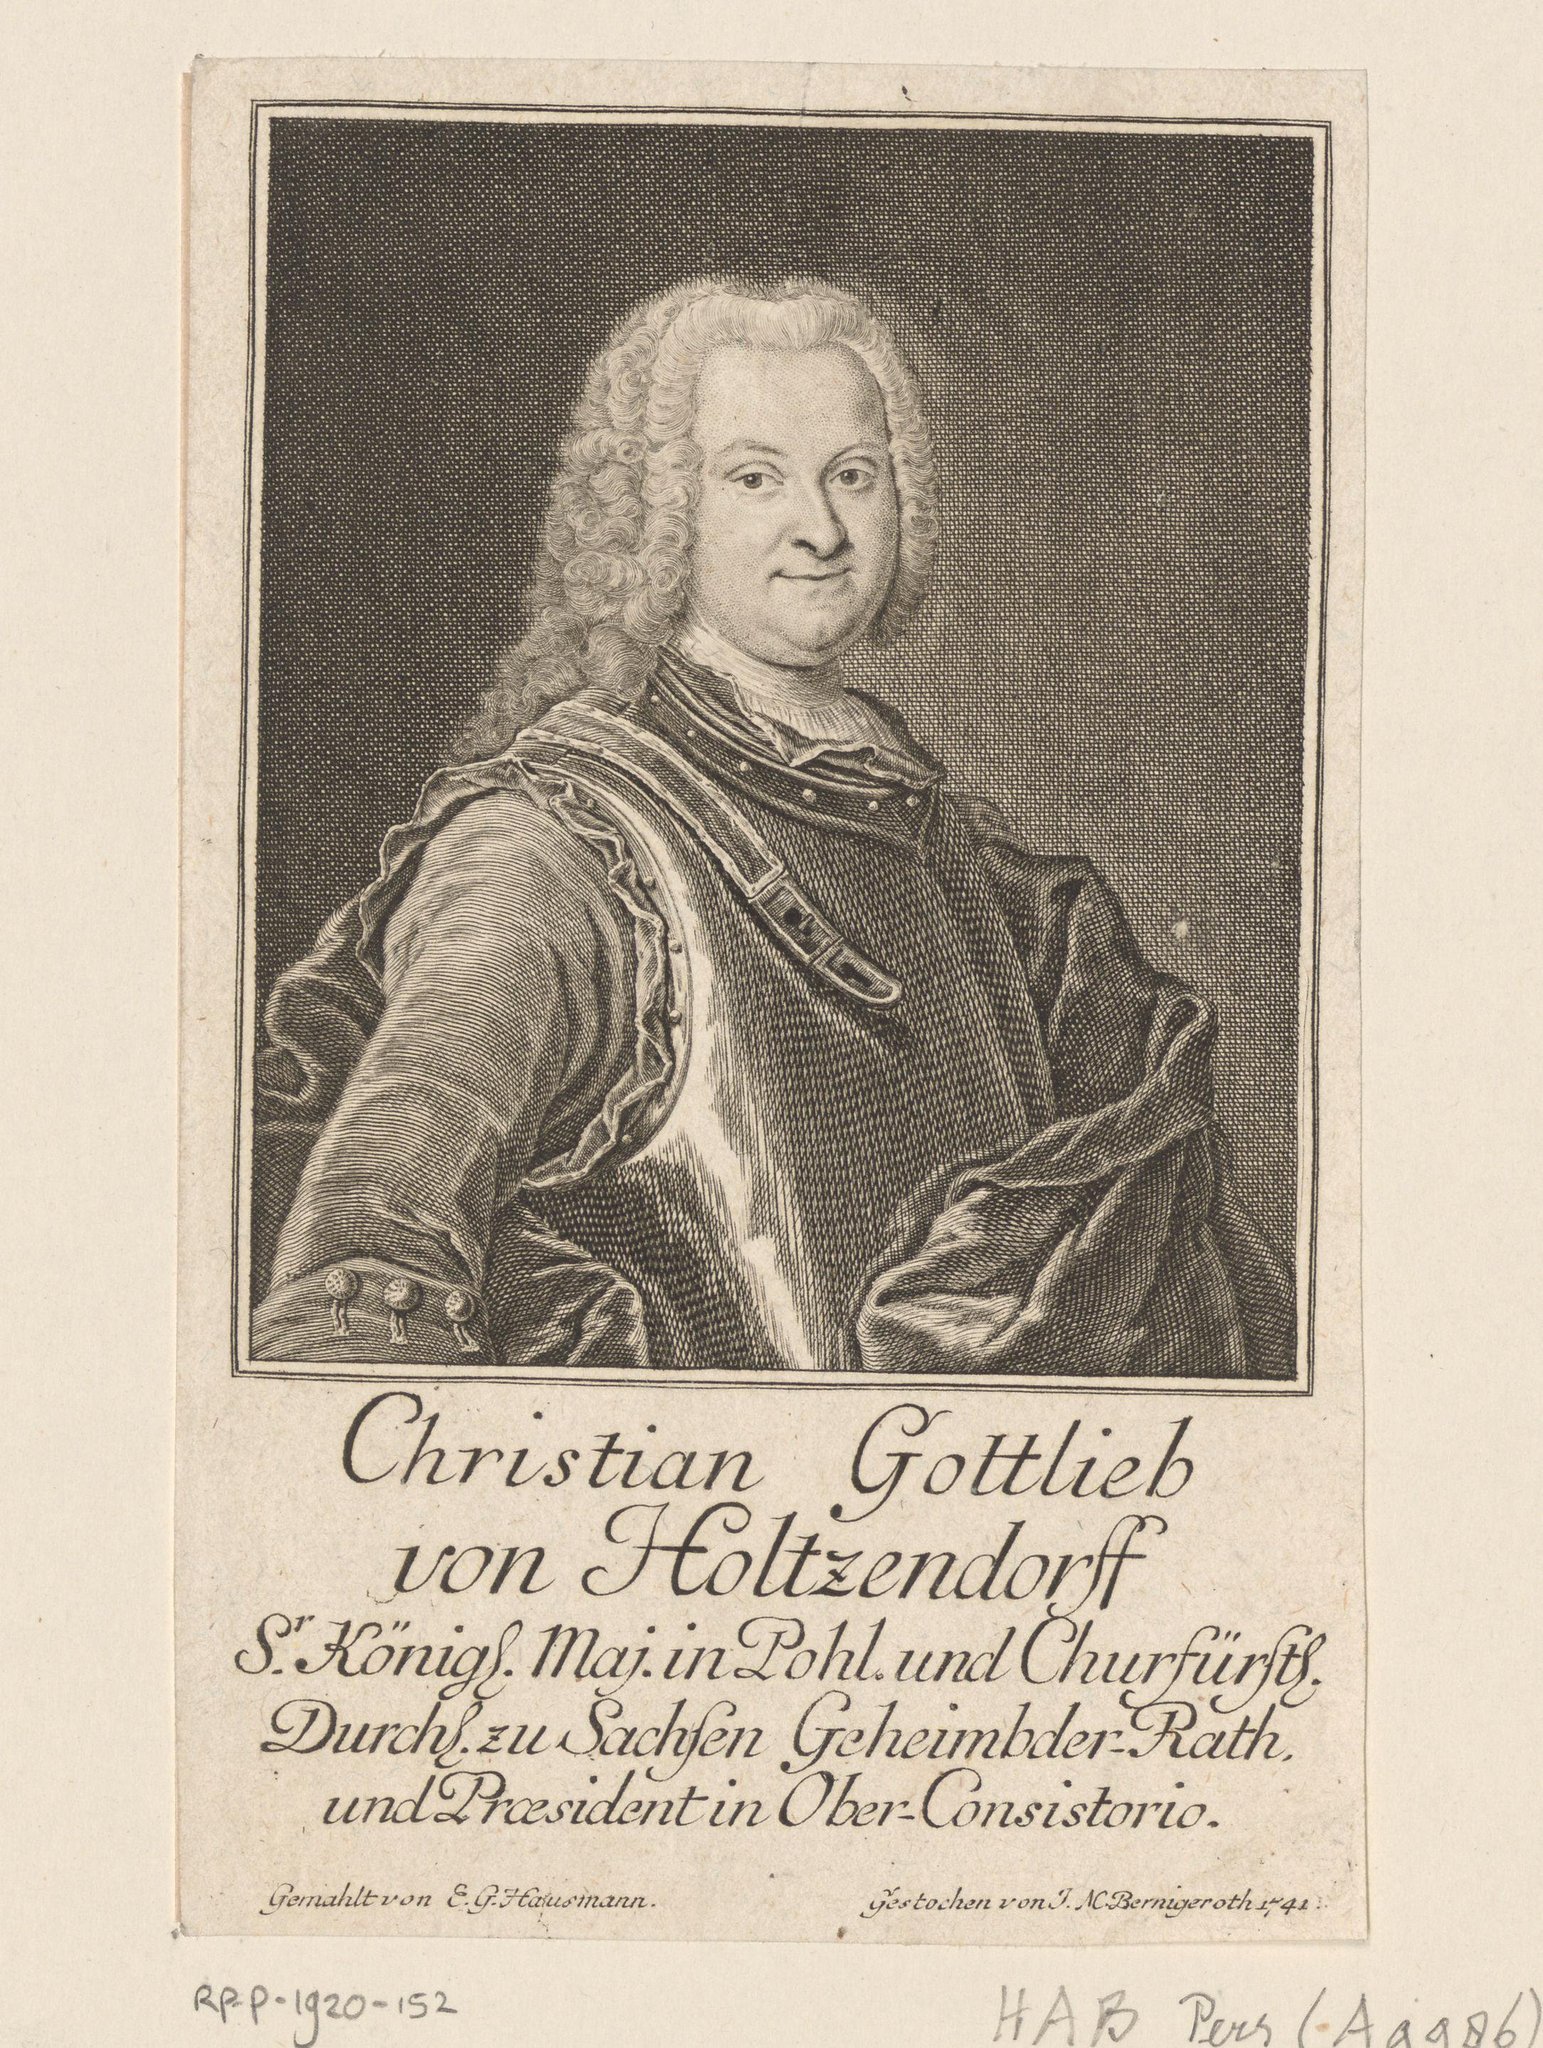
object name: print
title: Portret van Christian Gottlieb von Holtzendorff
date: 1741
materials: paper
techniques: engraving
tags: cuirass, adult man, historical persons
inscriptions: collector's mark: Lugt 2228